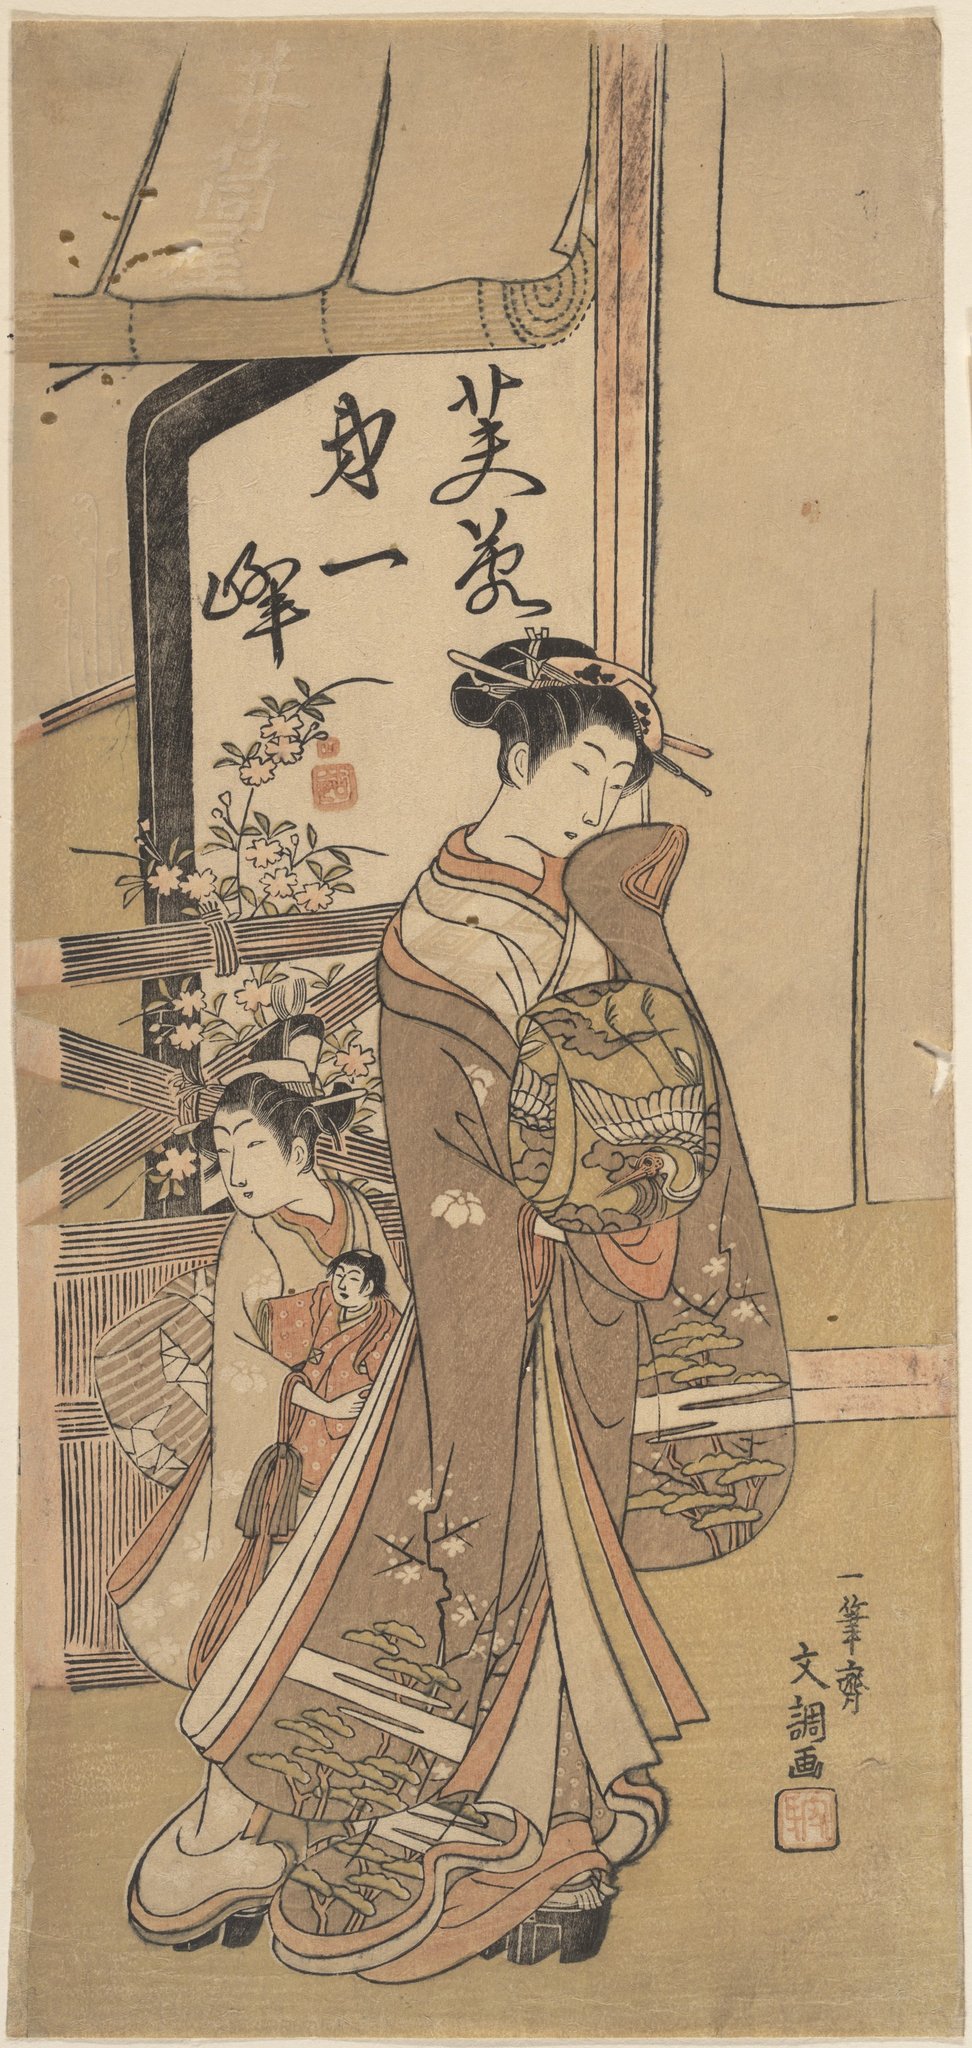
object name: print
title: A Courtesan Followed by a Girl Attendant Carrying a Doll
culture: japanese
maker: ippitsusai bunchō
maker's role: artist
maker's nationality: japanese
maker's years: 1765-1792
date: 1723-1792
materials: ink, paper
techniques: woodblock print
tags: girls,women,flowers